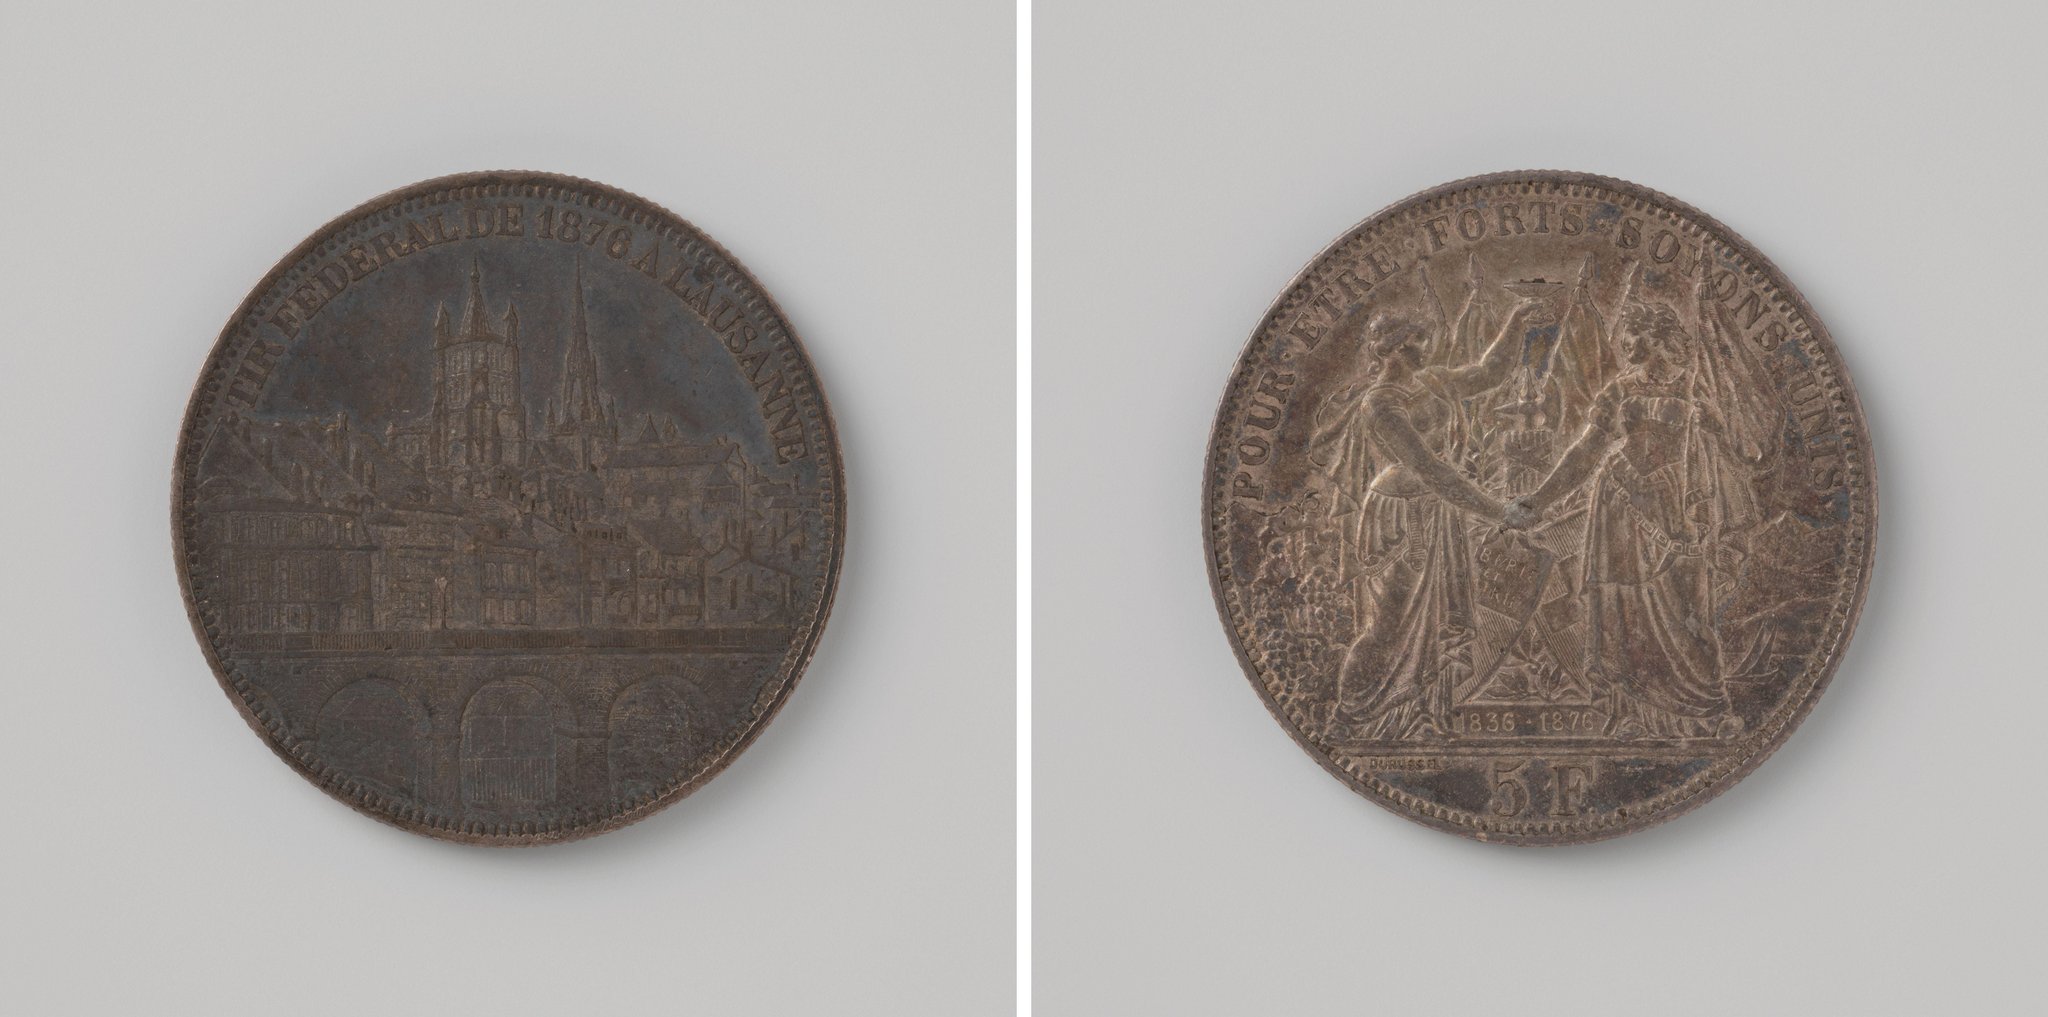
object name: coin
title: Zwitserland, 5 francs, tir federal Lausanne, 1876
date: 1876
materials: silver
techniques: striking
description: Zilveren herdenkingsmunt. Voorzijde: tafereel met twee, elkaar de hand reikende vrouwen op de voorgrond. Waarde-aanduiding: 5 F in afsnede. Keerzijde: stadsgezicht, jaartal in omschrift. Kartelrand.